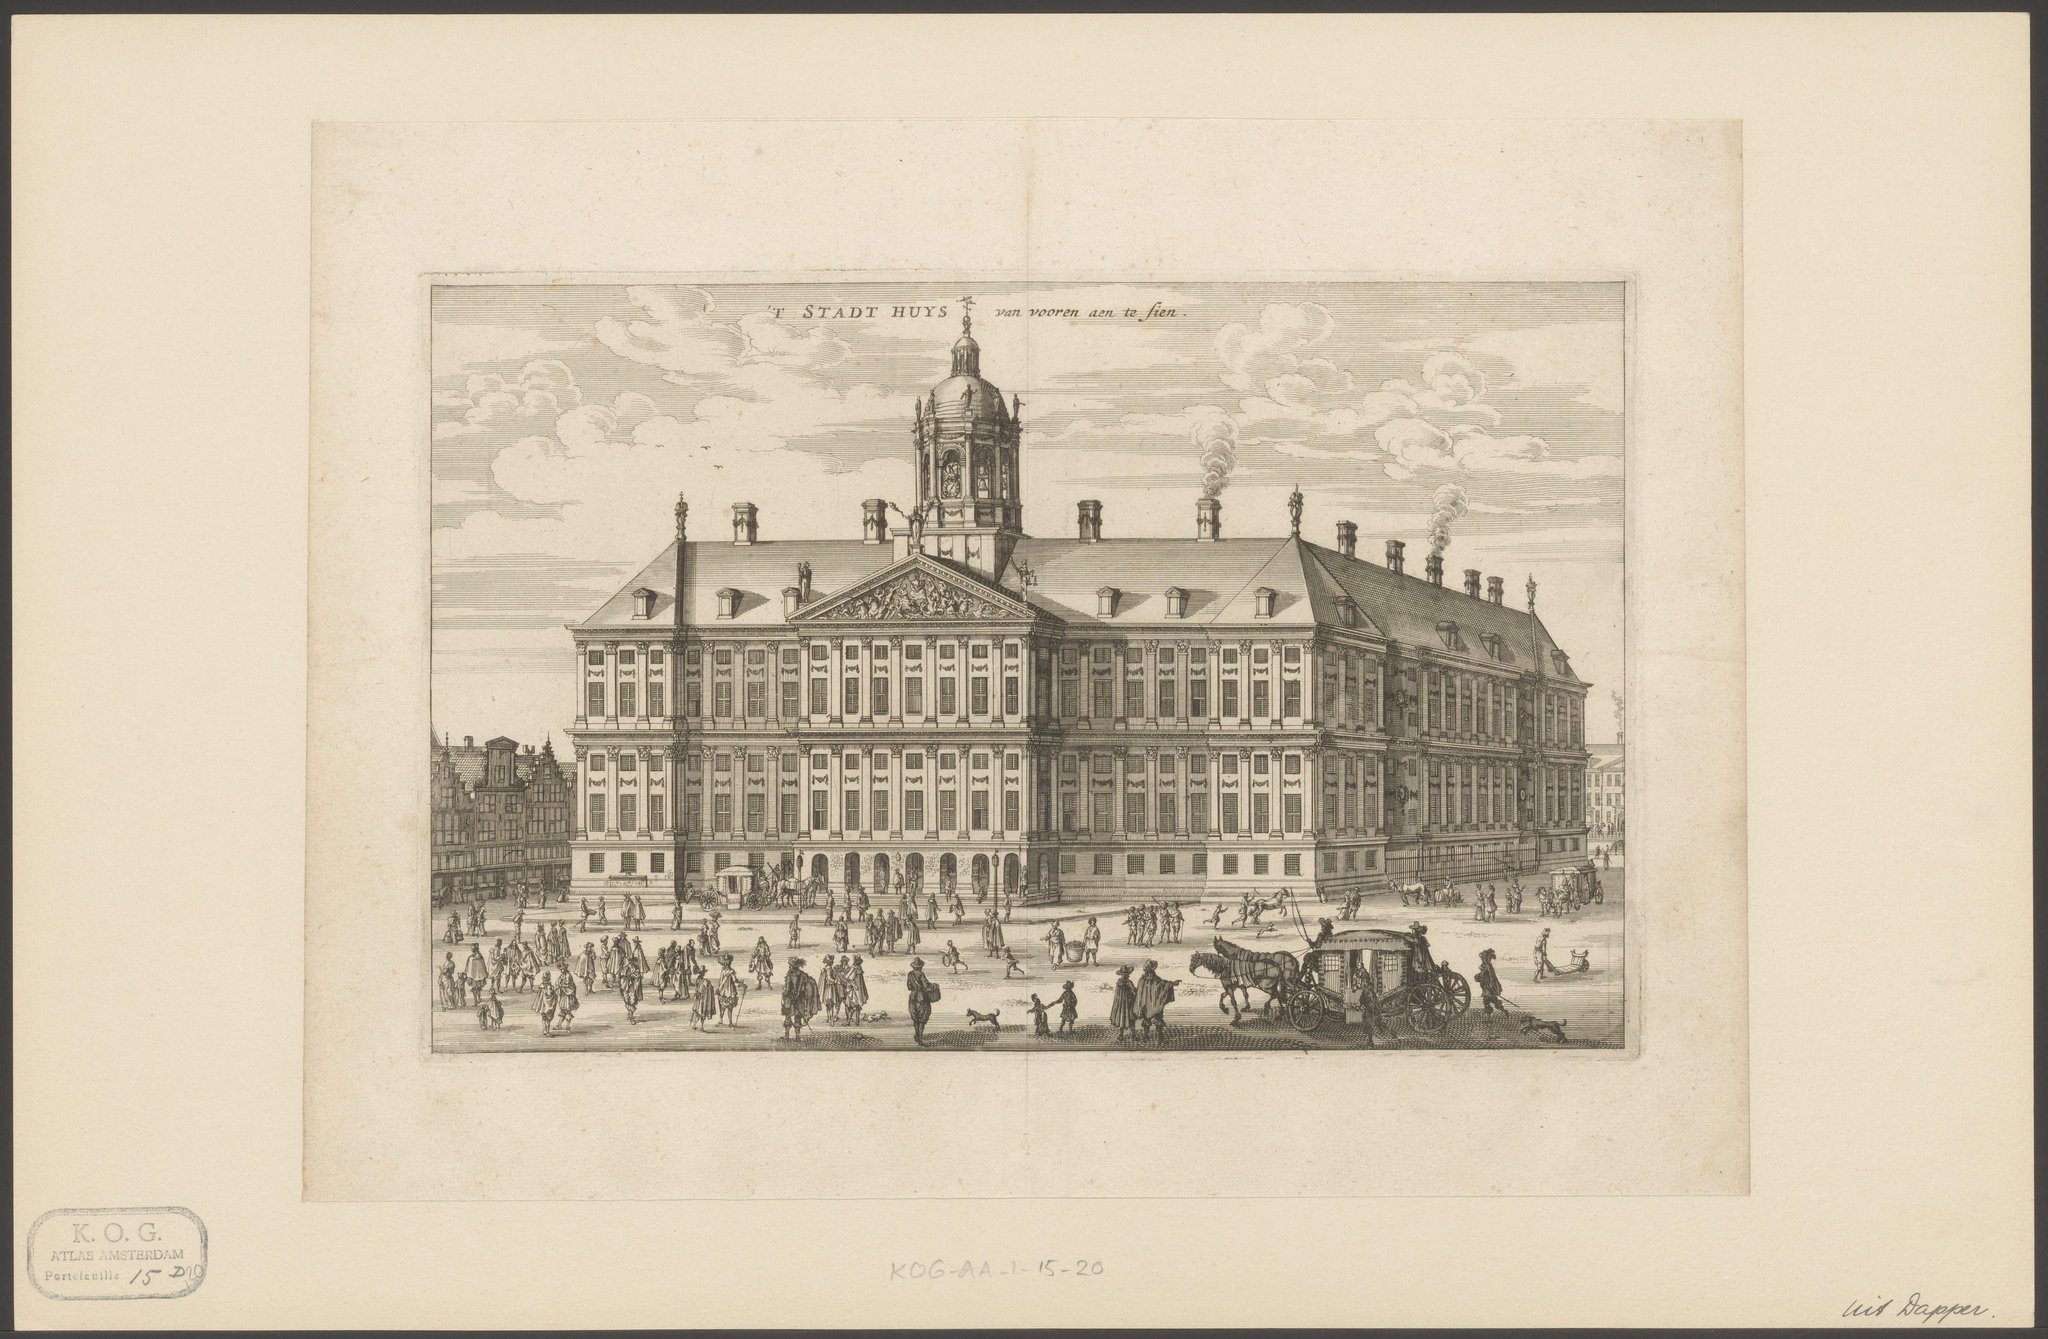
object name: print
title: 't Stadt huys van vooren aen te sien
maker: jacob van meurs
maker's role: draughtsman, print maker, publisher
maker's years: 1619-1680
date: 1663-1664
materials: paper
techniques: engraving, etching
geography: amsterdam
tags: city-view in general; 'veduta', townhall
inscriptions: collector's mark: ‘15D,20’ Lugt 1641b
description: Huidige staat van prent ook gebruikt in: Dapper, Olfert. Historische beschryving der stadt Amsterdam: waer in de voornaemste geschiedenissen (na een kort verhael van gansch Hollant en d'omleggende dorpen (…). Amsterdam: Jacob van Meurs, 1663.* En in: Zesen, Philipp von. Beschreibung der Stadt Amsterdam: darinnen von derselben ersten Ursprunge bis auf gegenwärtigen Zustand (…). Amsterdam: Joachim Nosche, 1664. * In sommige exemplaren van deze uitgave komt de huidige staat van de prent voor. In andere exemplaren is een latere staat ingebonden, waarop boven de Nederlandse een Franse titel is toegevoegd.